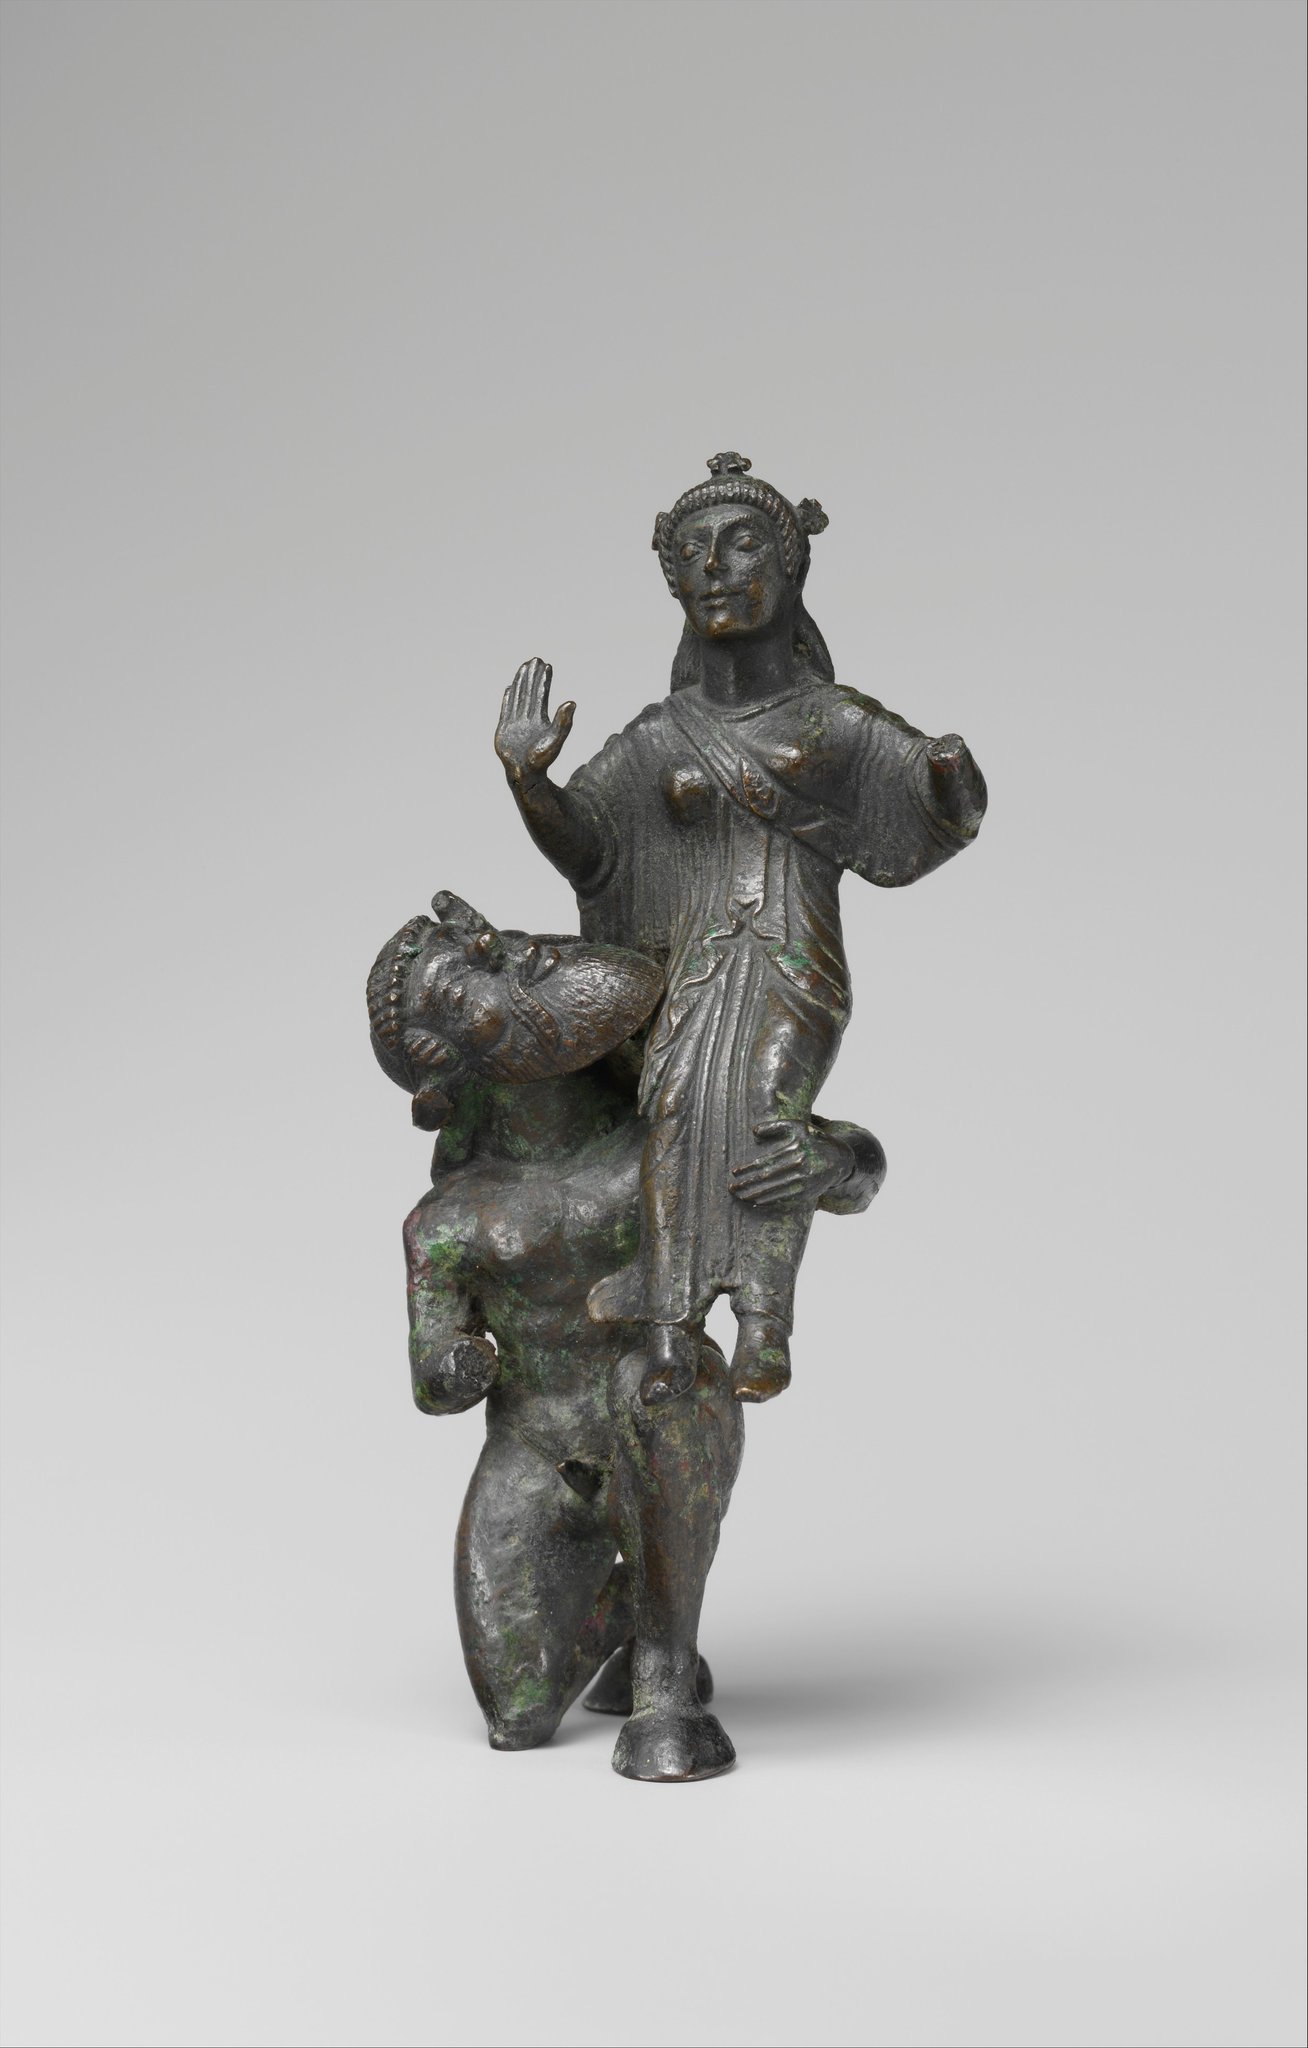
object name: statuette of a satyr and nymph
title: Bronze statuette of a satyr and maenad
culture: etruscan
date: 510-480 BCE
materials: bronze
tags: maenads,satyrs